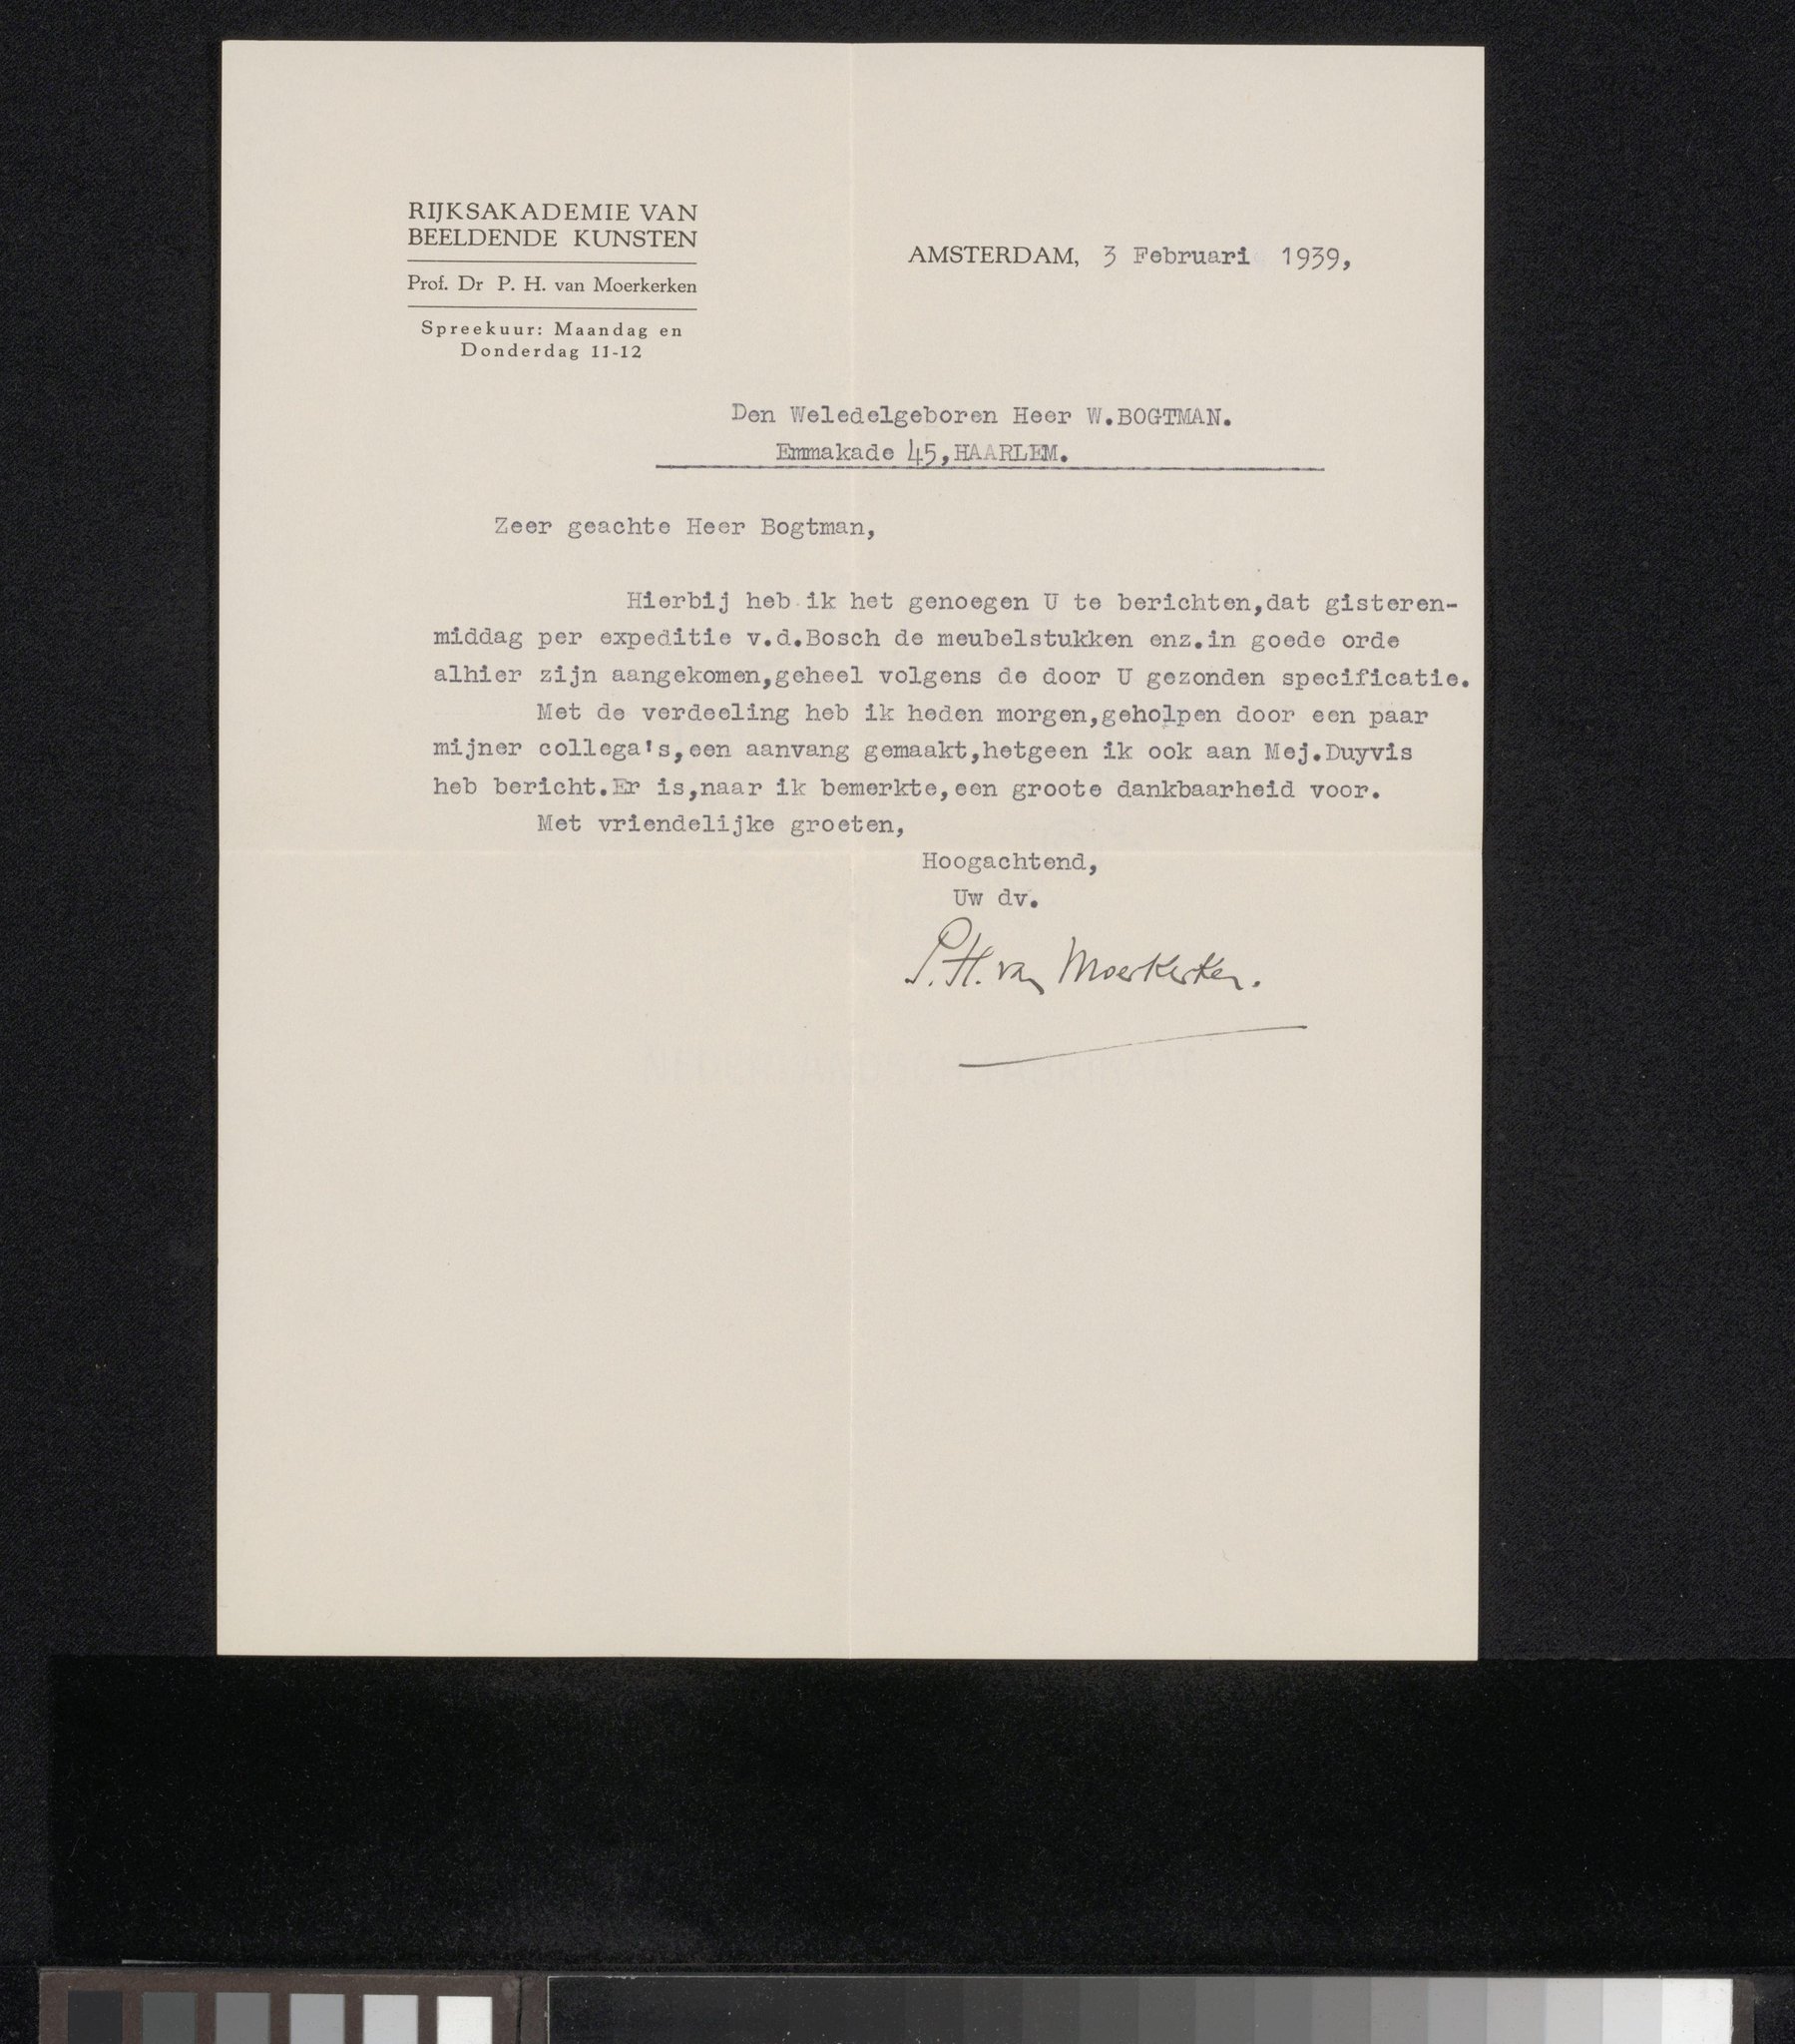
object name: letter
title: Brief aan Willem Bogtman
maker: pieter hendrik van moerkerken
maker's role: print maker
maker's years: 1877-1951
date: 1939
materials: ink, paper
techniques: pen, typewriting, writing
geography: amsterdam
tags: amsterdam, print maker, draughtsman, debora duyvis, haarlem, willem bogtman, applied arts, arts and crafts; industrial design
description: Brief betreft de nalatenschap van Richard Roland Holst.